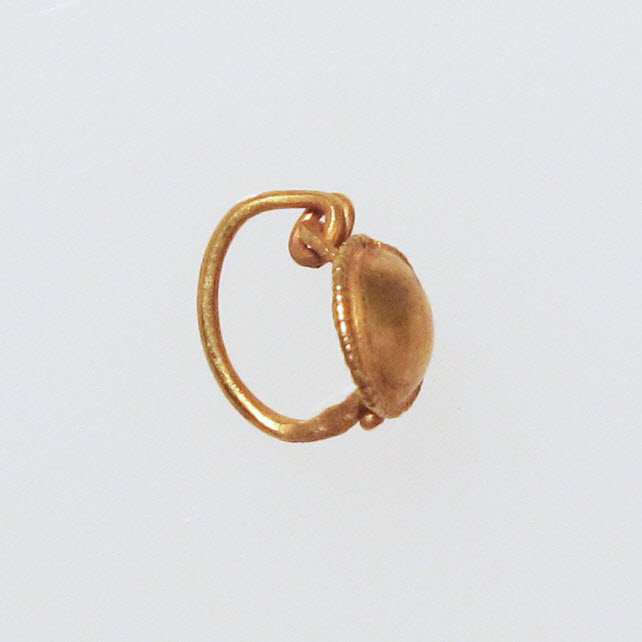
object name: earring with plain loop and disc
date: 7000 BCE-330 CE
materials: gold